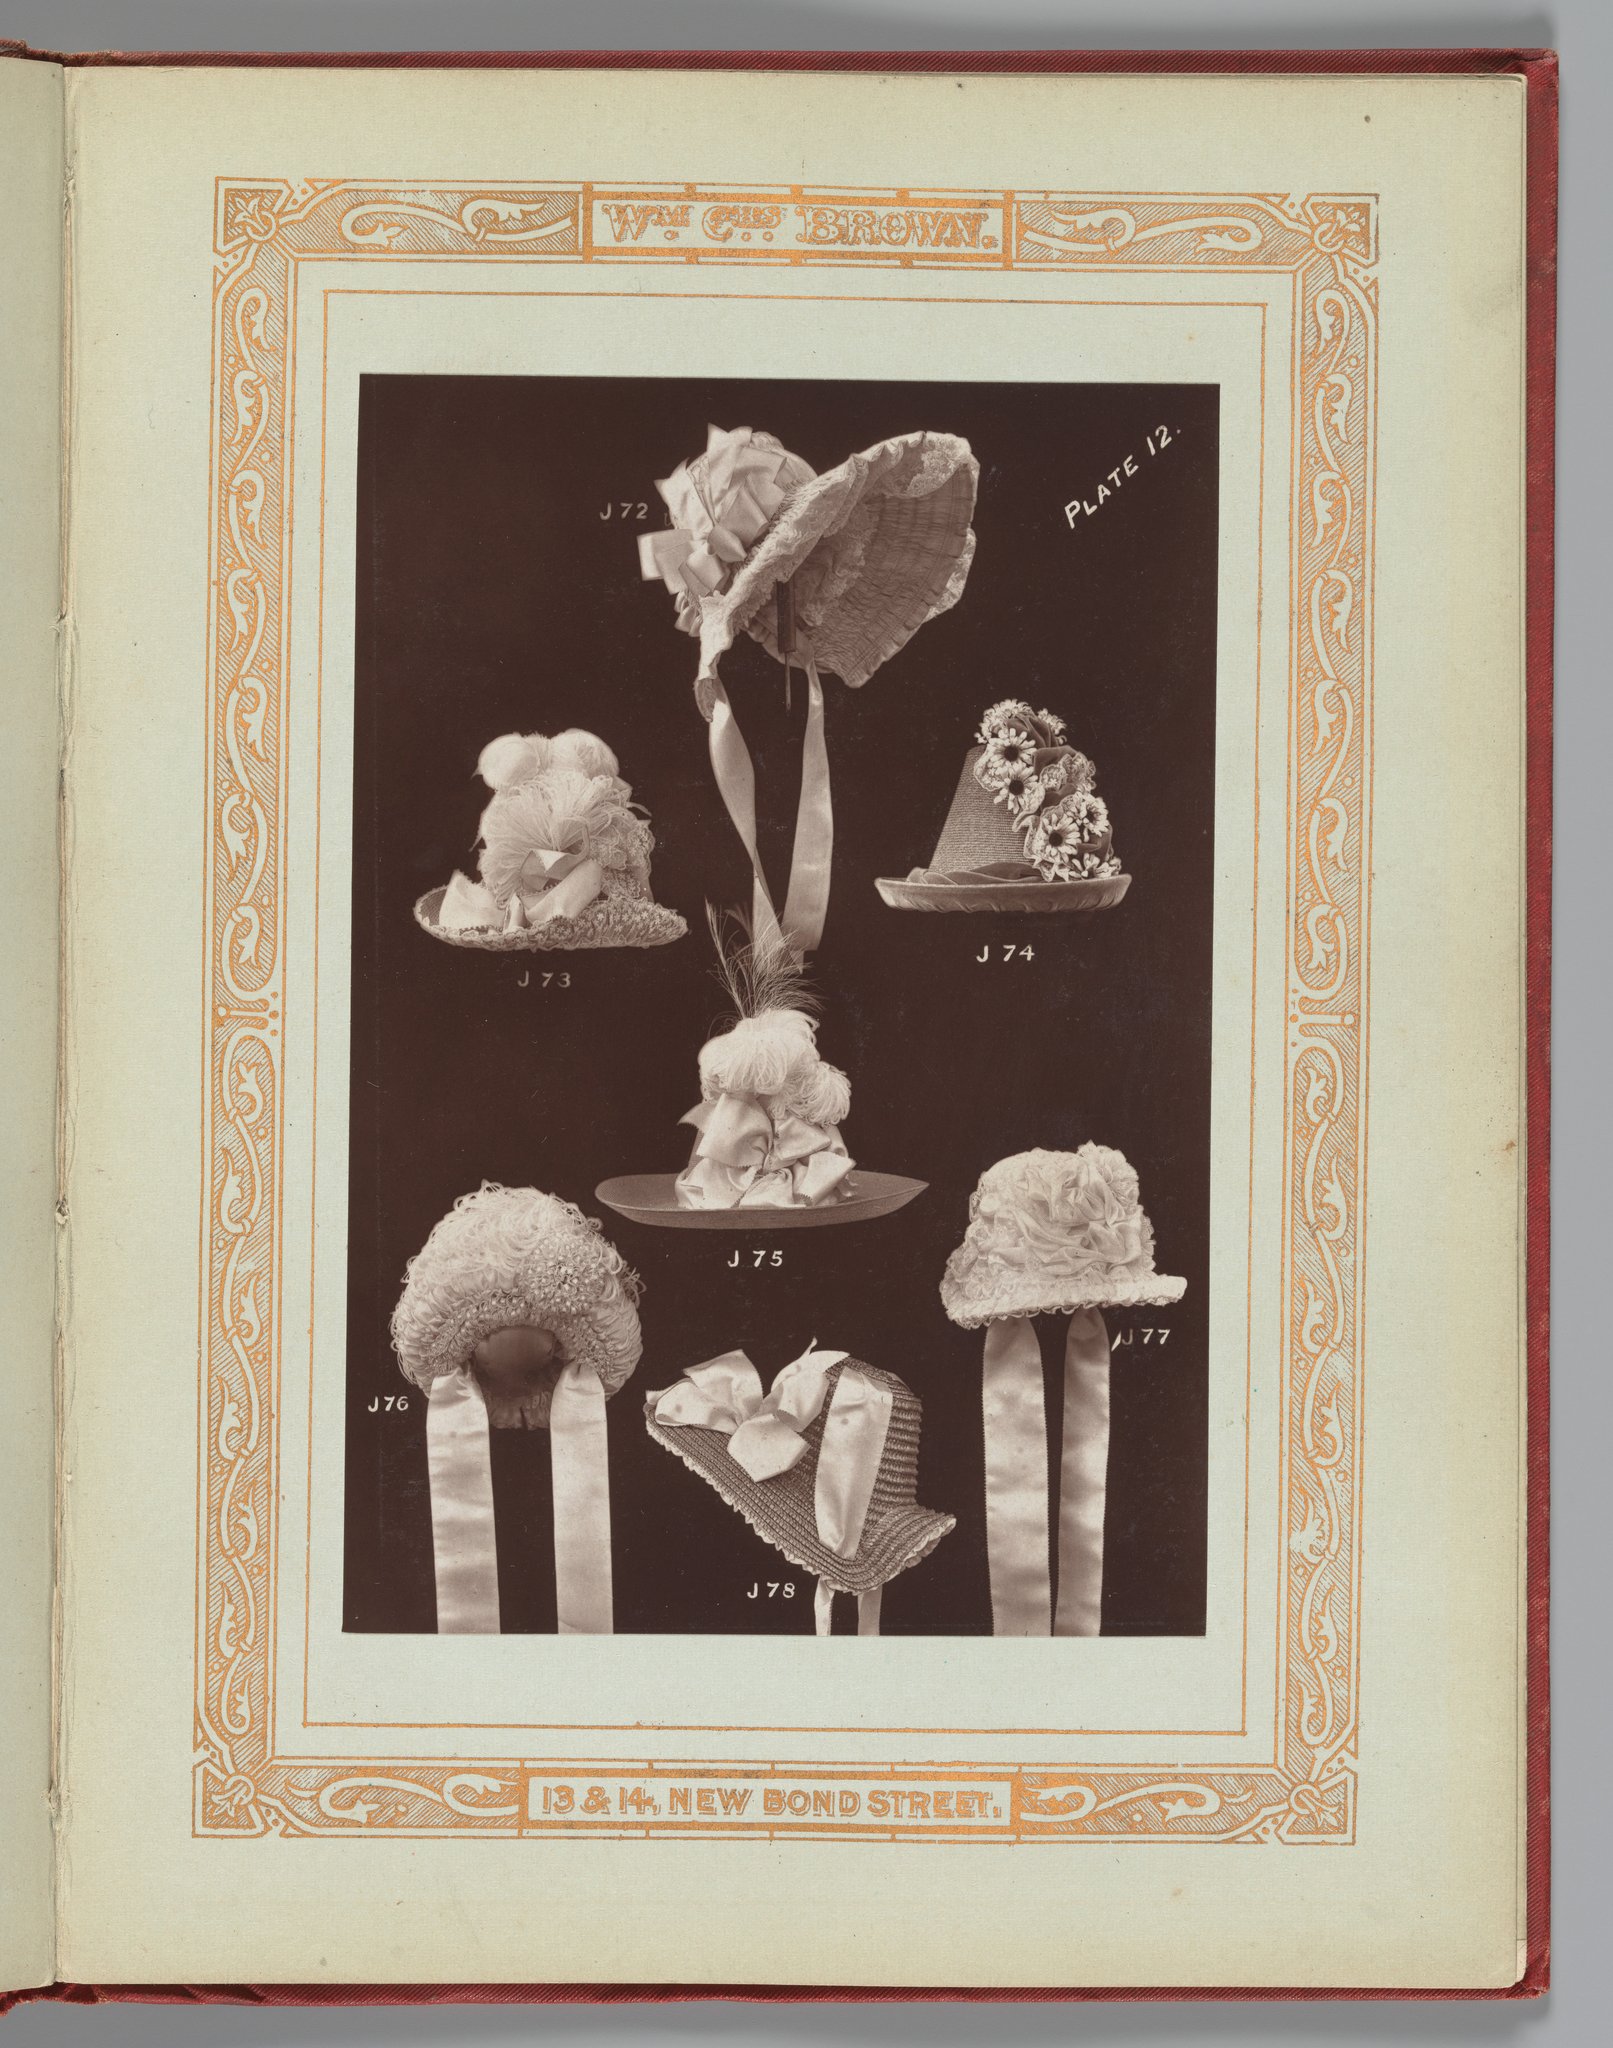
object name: photographically illustrated book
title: [Hats J72-J78]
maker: william charles brown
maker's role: author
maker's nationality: british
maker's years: 1800-1899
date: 1888